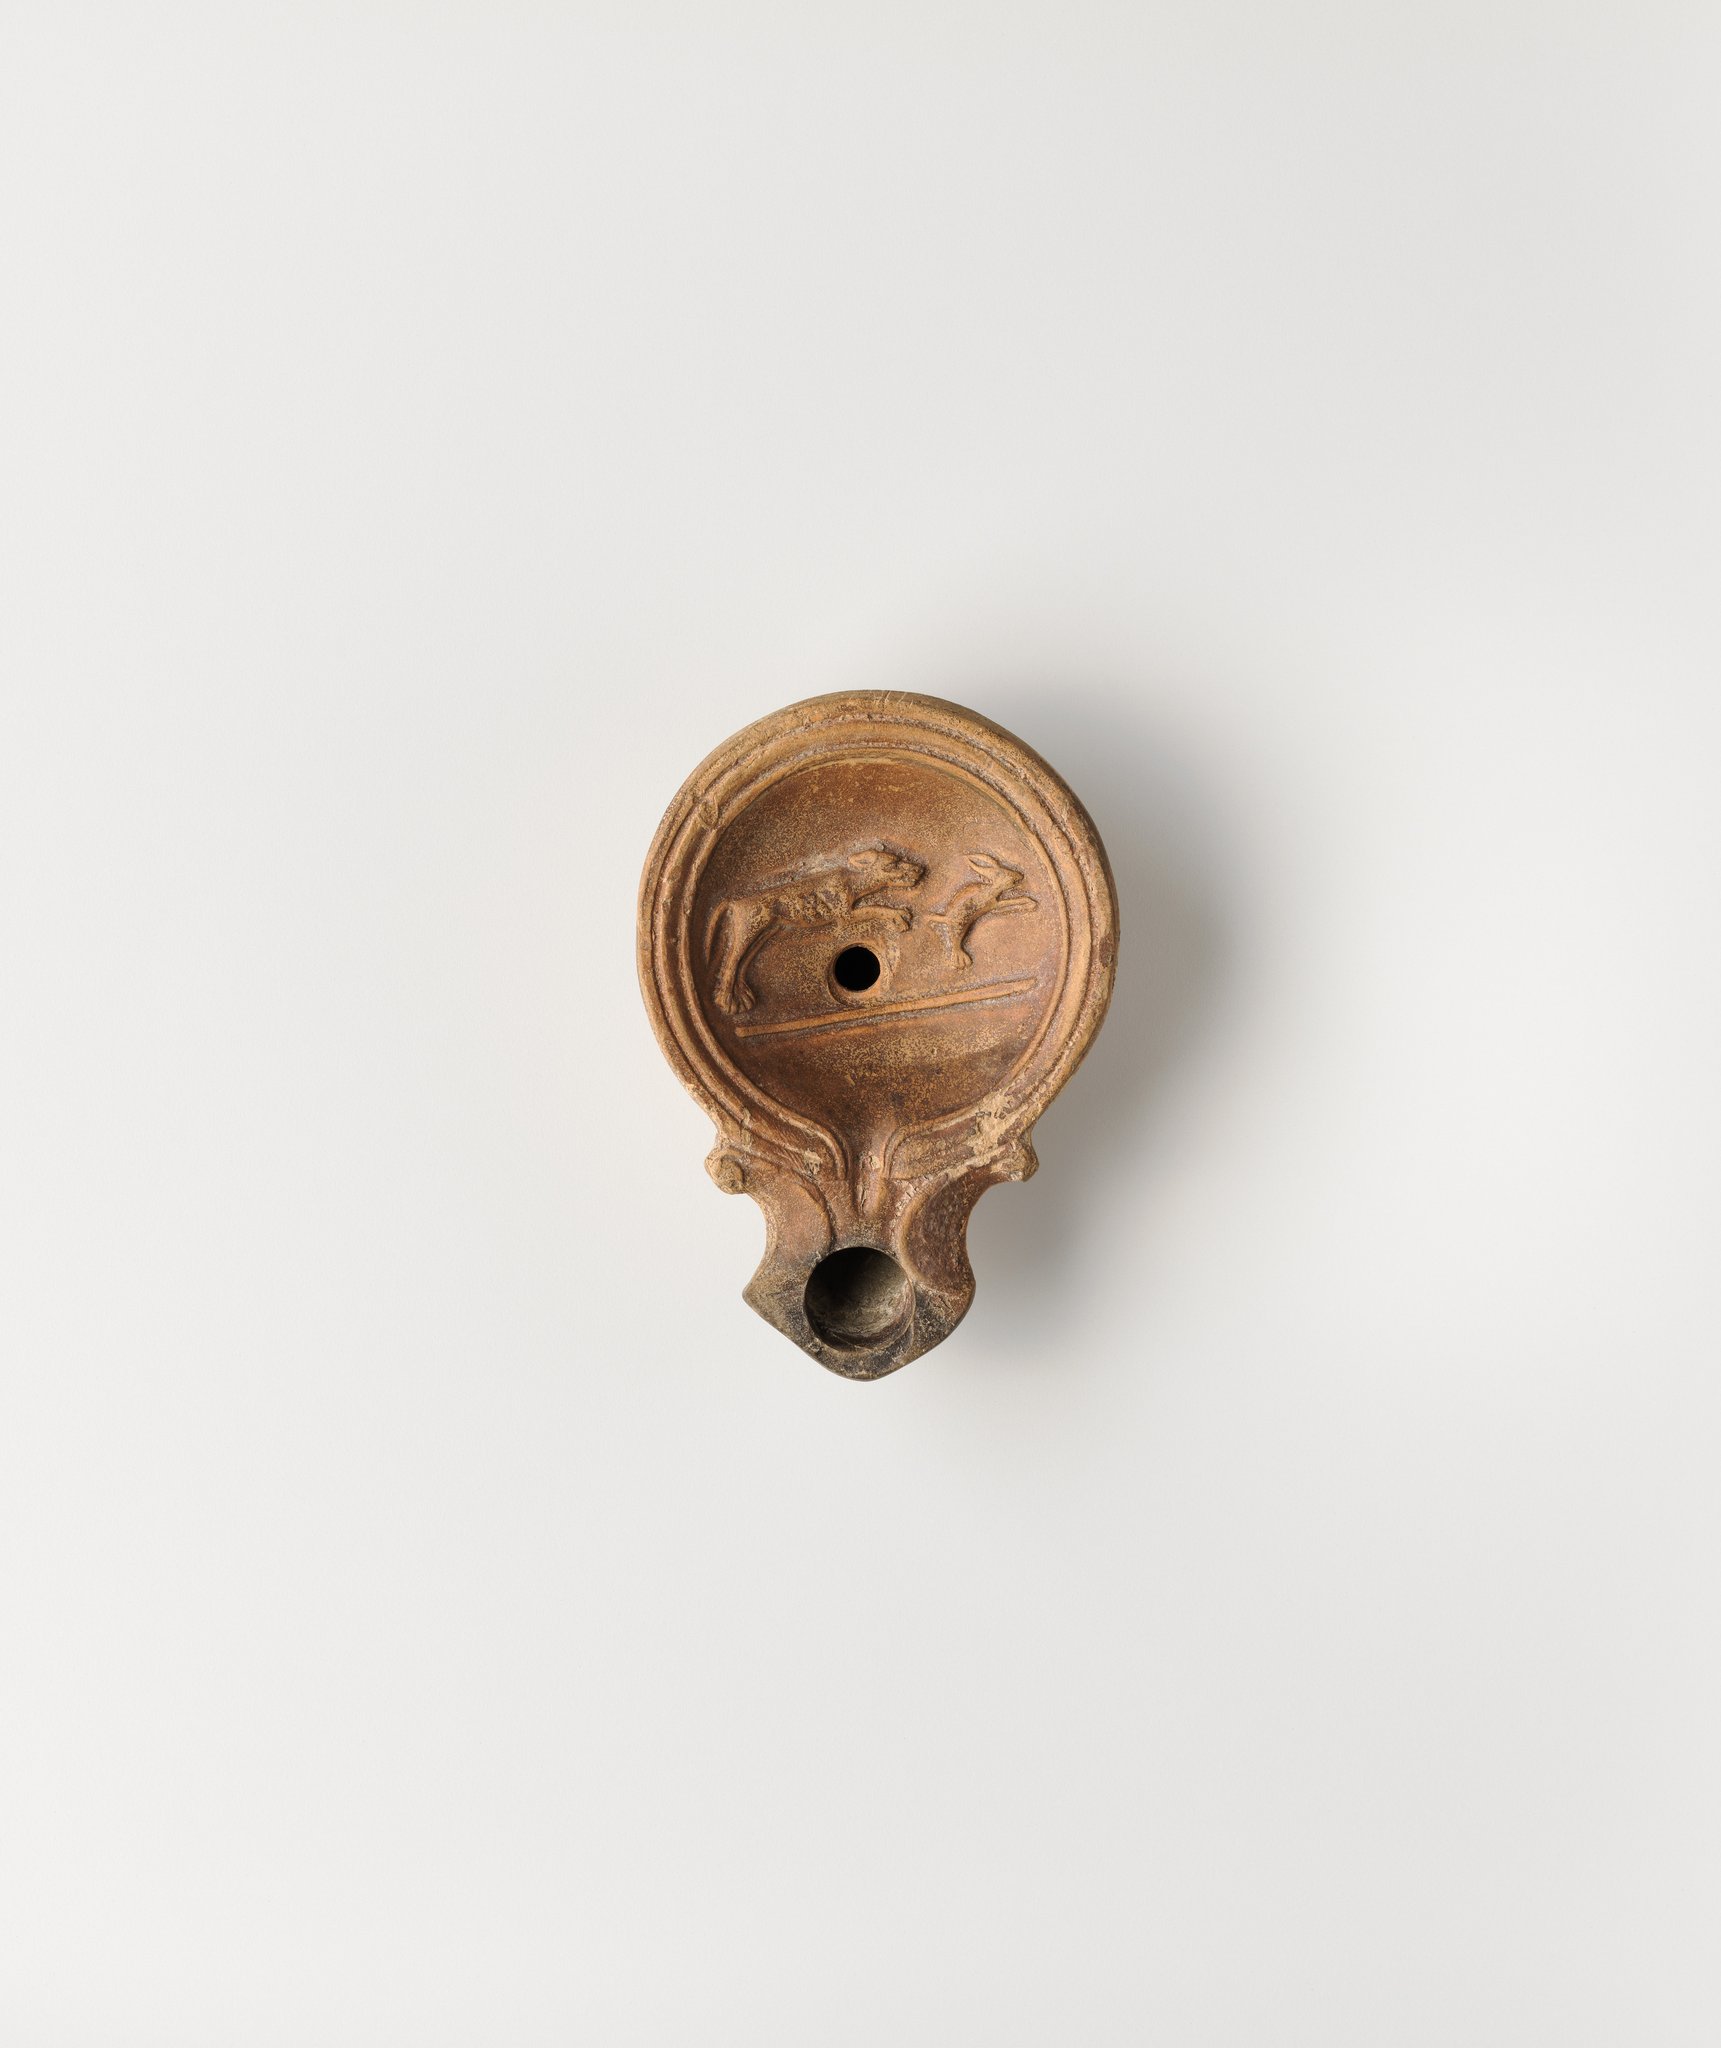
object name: lamp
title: Terracotta oil lamp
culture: roman, cypriot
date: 27 BCE-38 CE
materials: terracotta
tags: dogs,rabbits